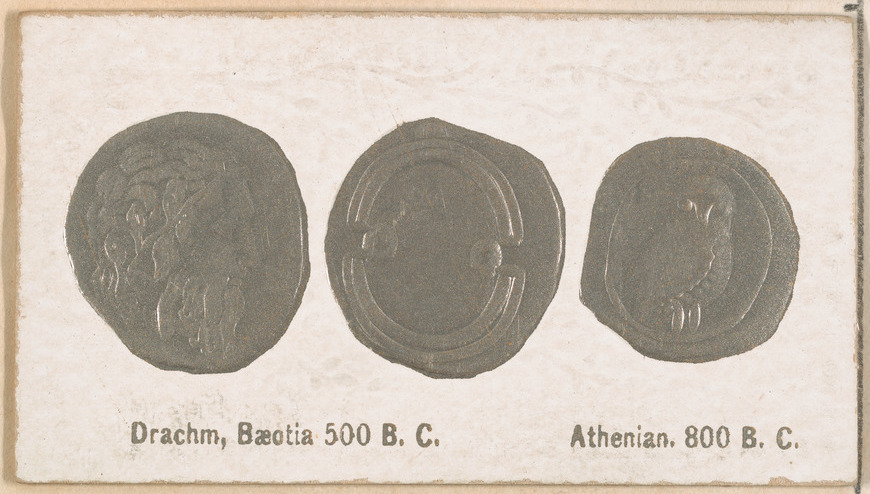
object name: print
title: Drachm Baeotia 500 B.C. / Athenian, 800 B.C., from the Ancient Coins series (N180) issued by Wm. S. Kimball & Co.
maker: william s. kimball & company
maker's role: publisher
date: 1888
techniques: color lithograph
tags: coins